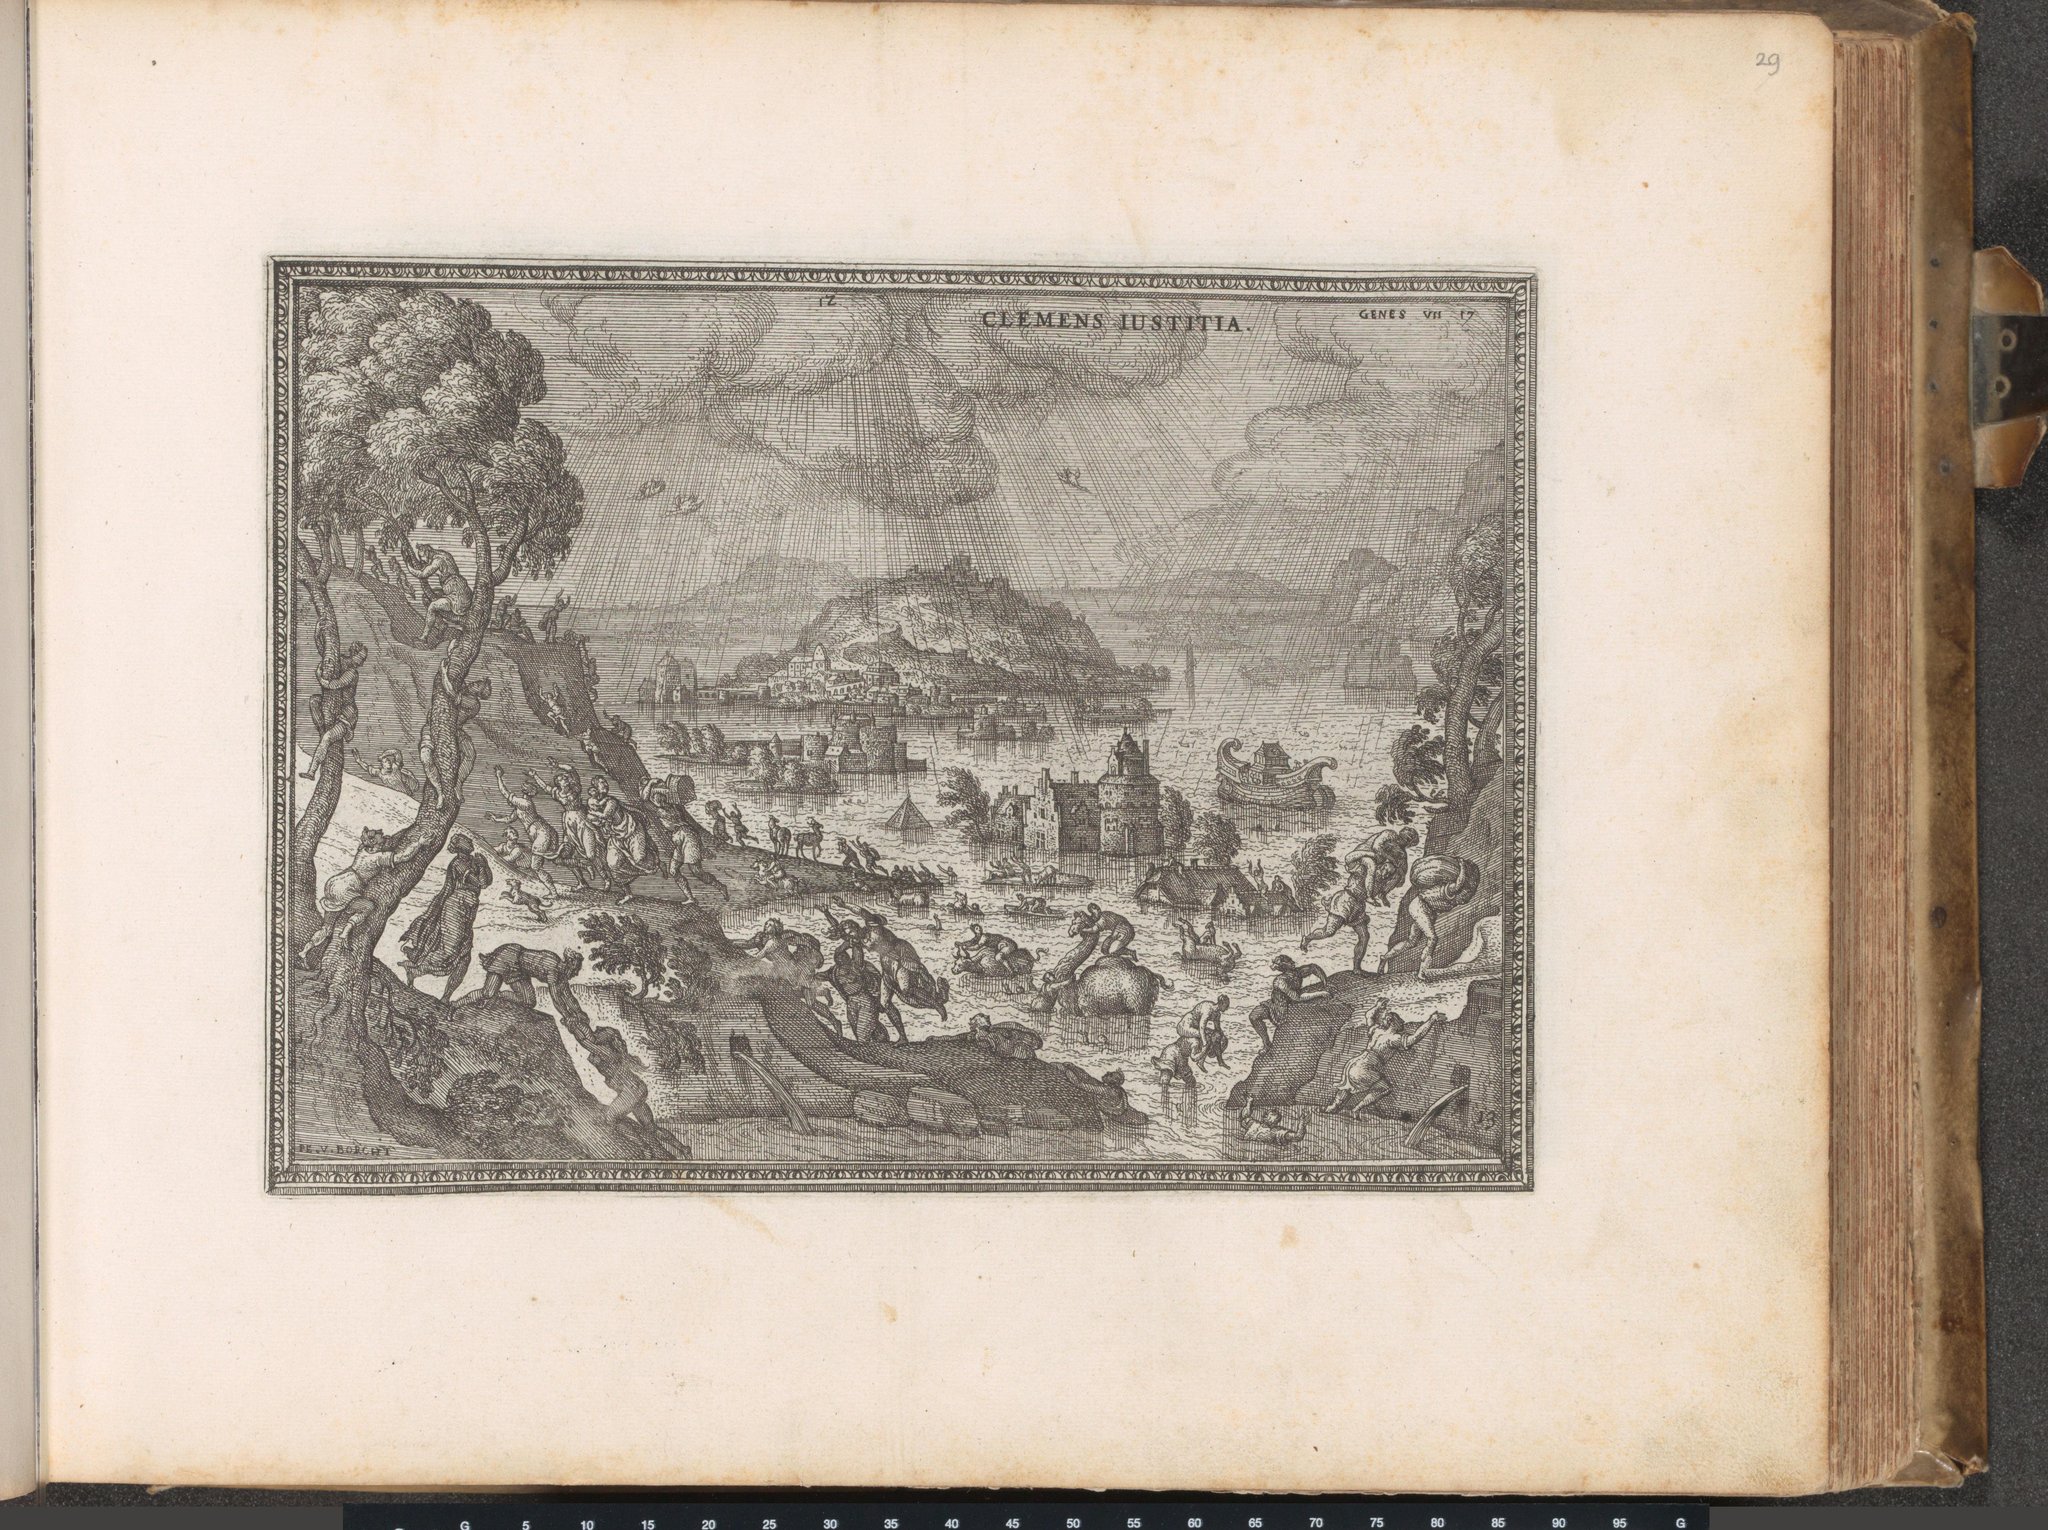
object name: album leaf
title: Imagines et figurae bibliorum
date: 1582-1593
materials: paper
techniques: etching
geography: amsterdam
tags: the ark is floating on the waters, while life on earth is destroyed ~ story of noah, old testament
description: De zondvloed. Het regent en het land staat onder water. Op de voorgrond proberen de mensen zich op hoger gelegen land in veiligheid te brengen. Links zijn mensen in de boom geklommen (Gen. 7:17). De prent maakt deel uit van een album.